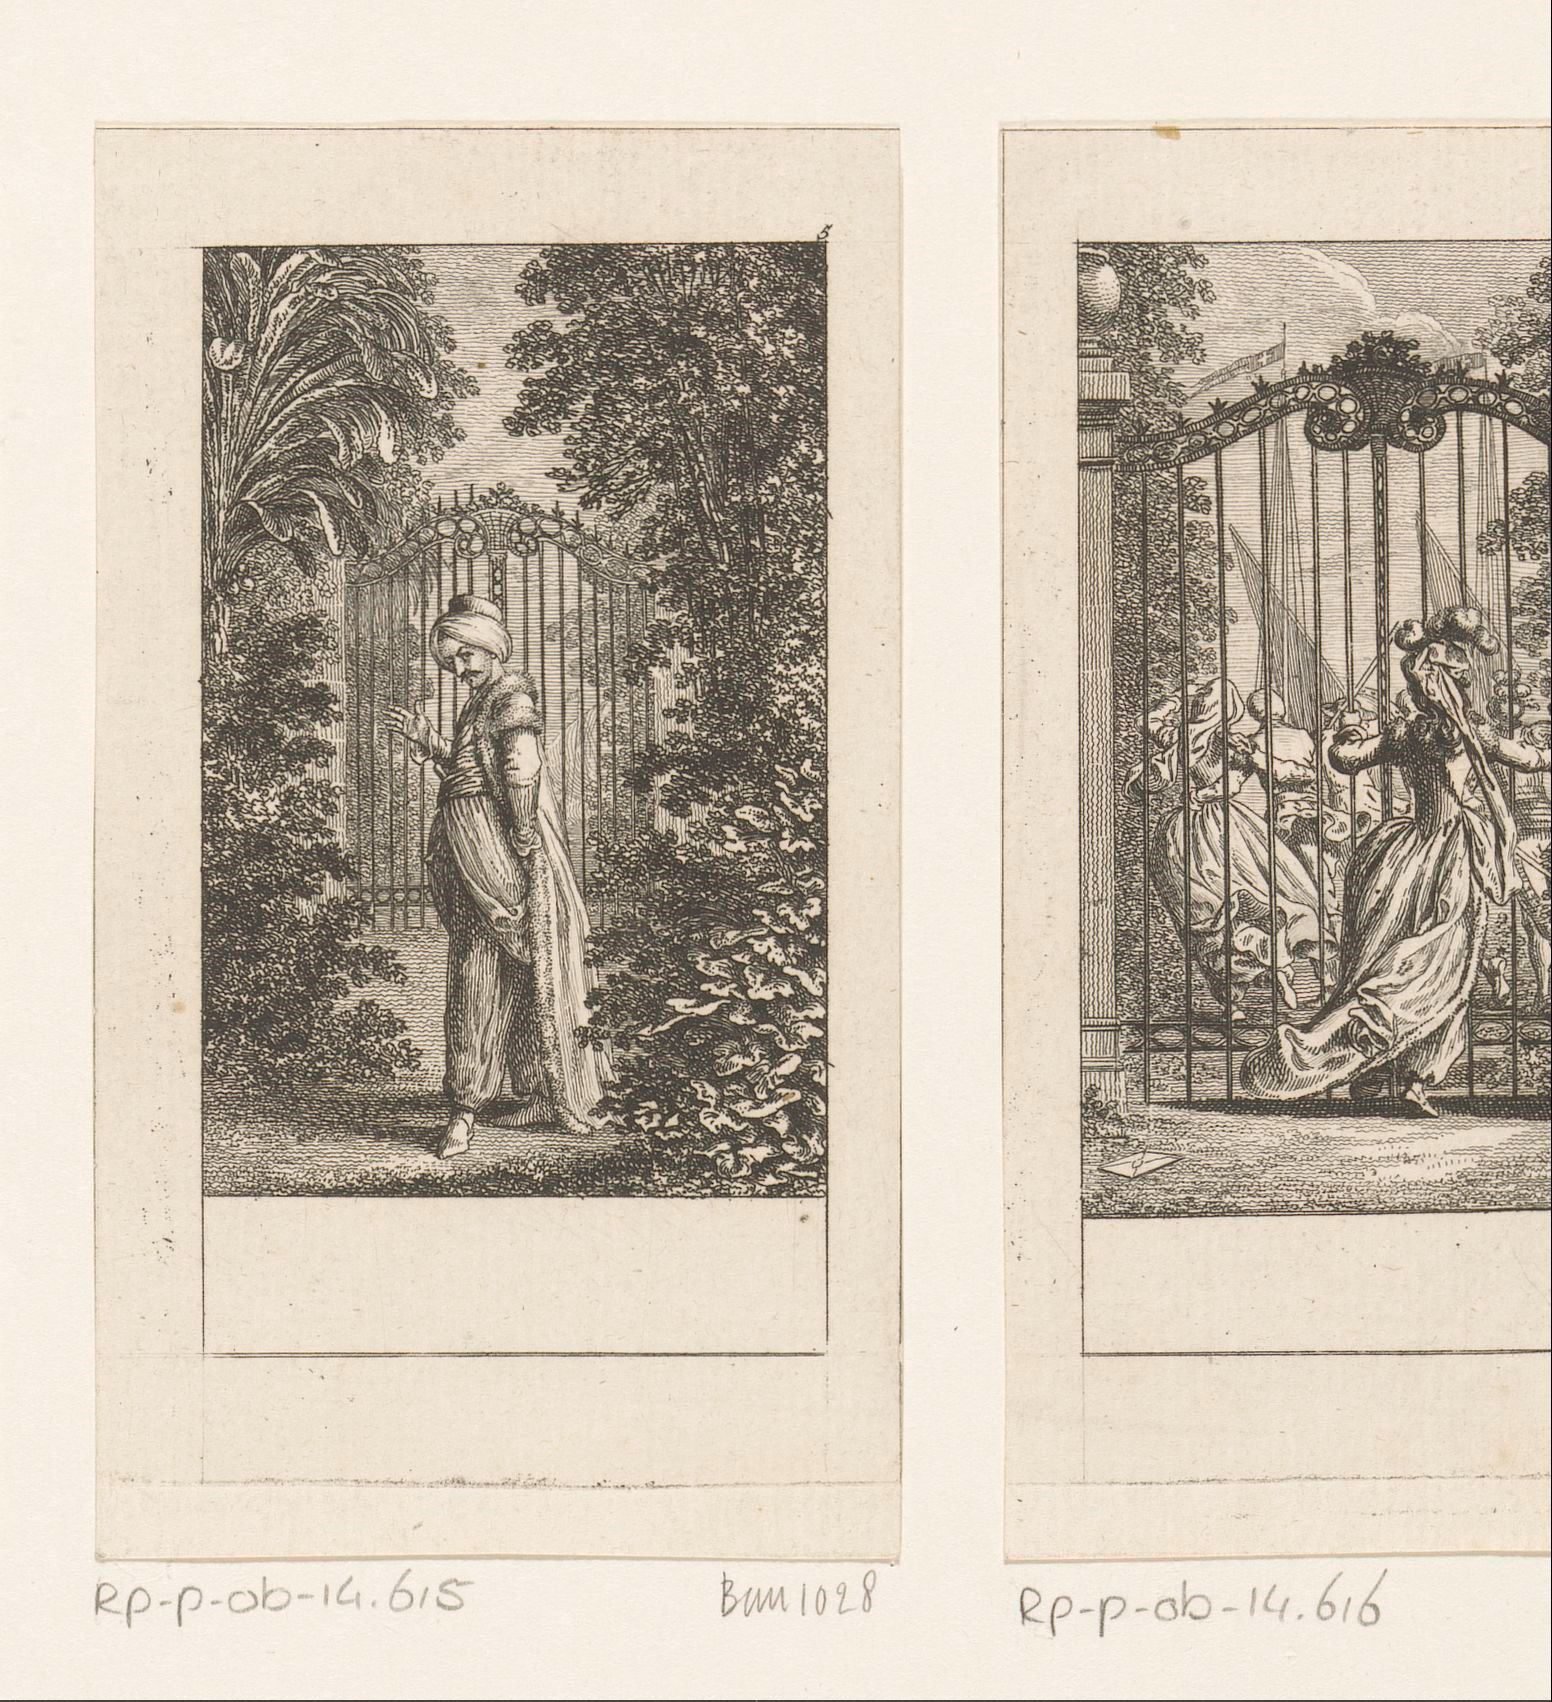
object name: print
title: Bassa neemt in de tuin zijn liefde voor Adelheid in beschouwing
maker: daniel nikolaus chodowiecki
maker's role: draughtsman, print maker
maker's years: 1726-1801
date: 1783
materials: paper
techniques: etching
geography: berlin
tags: berlin, plan, map of garden, literature, head-gear: turban, gate, entrance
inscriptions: collector's mark: Lugt 2228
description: Vervaardigd voor G. F. W. Grossmann's 'Adelheid von Veltheim'. Een latere staat gebruikt in: Königlich Grosbritannischer genealogischer Kalender auf das Jahr 1784. Lauenburg: Berenberg, 1783.